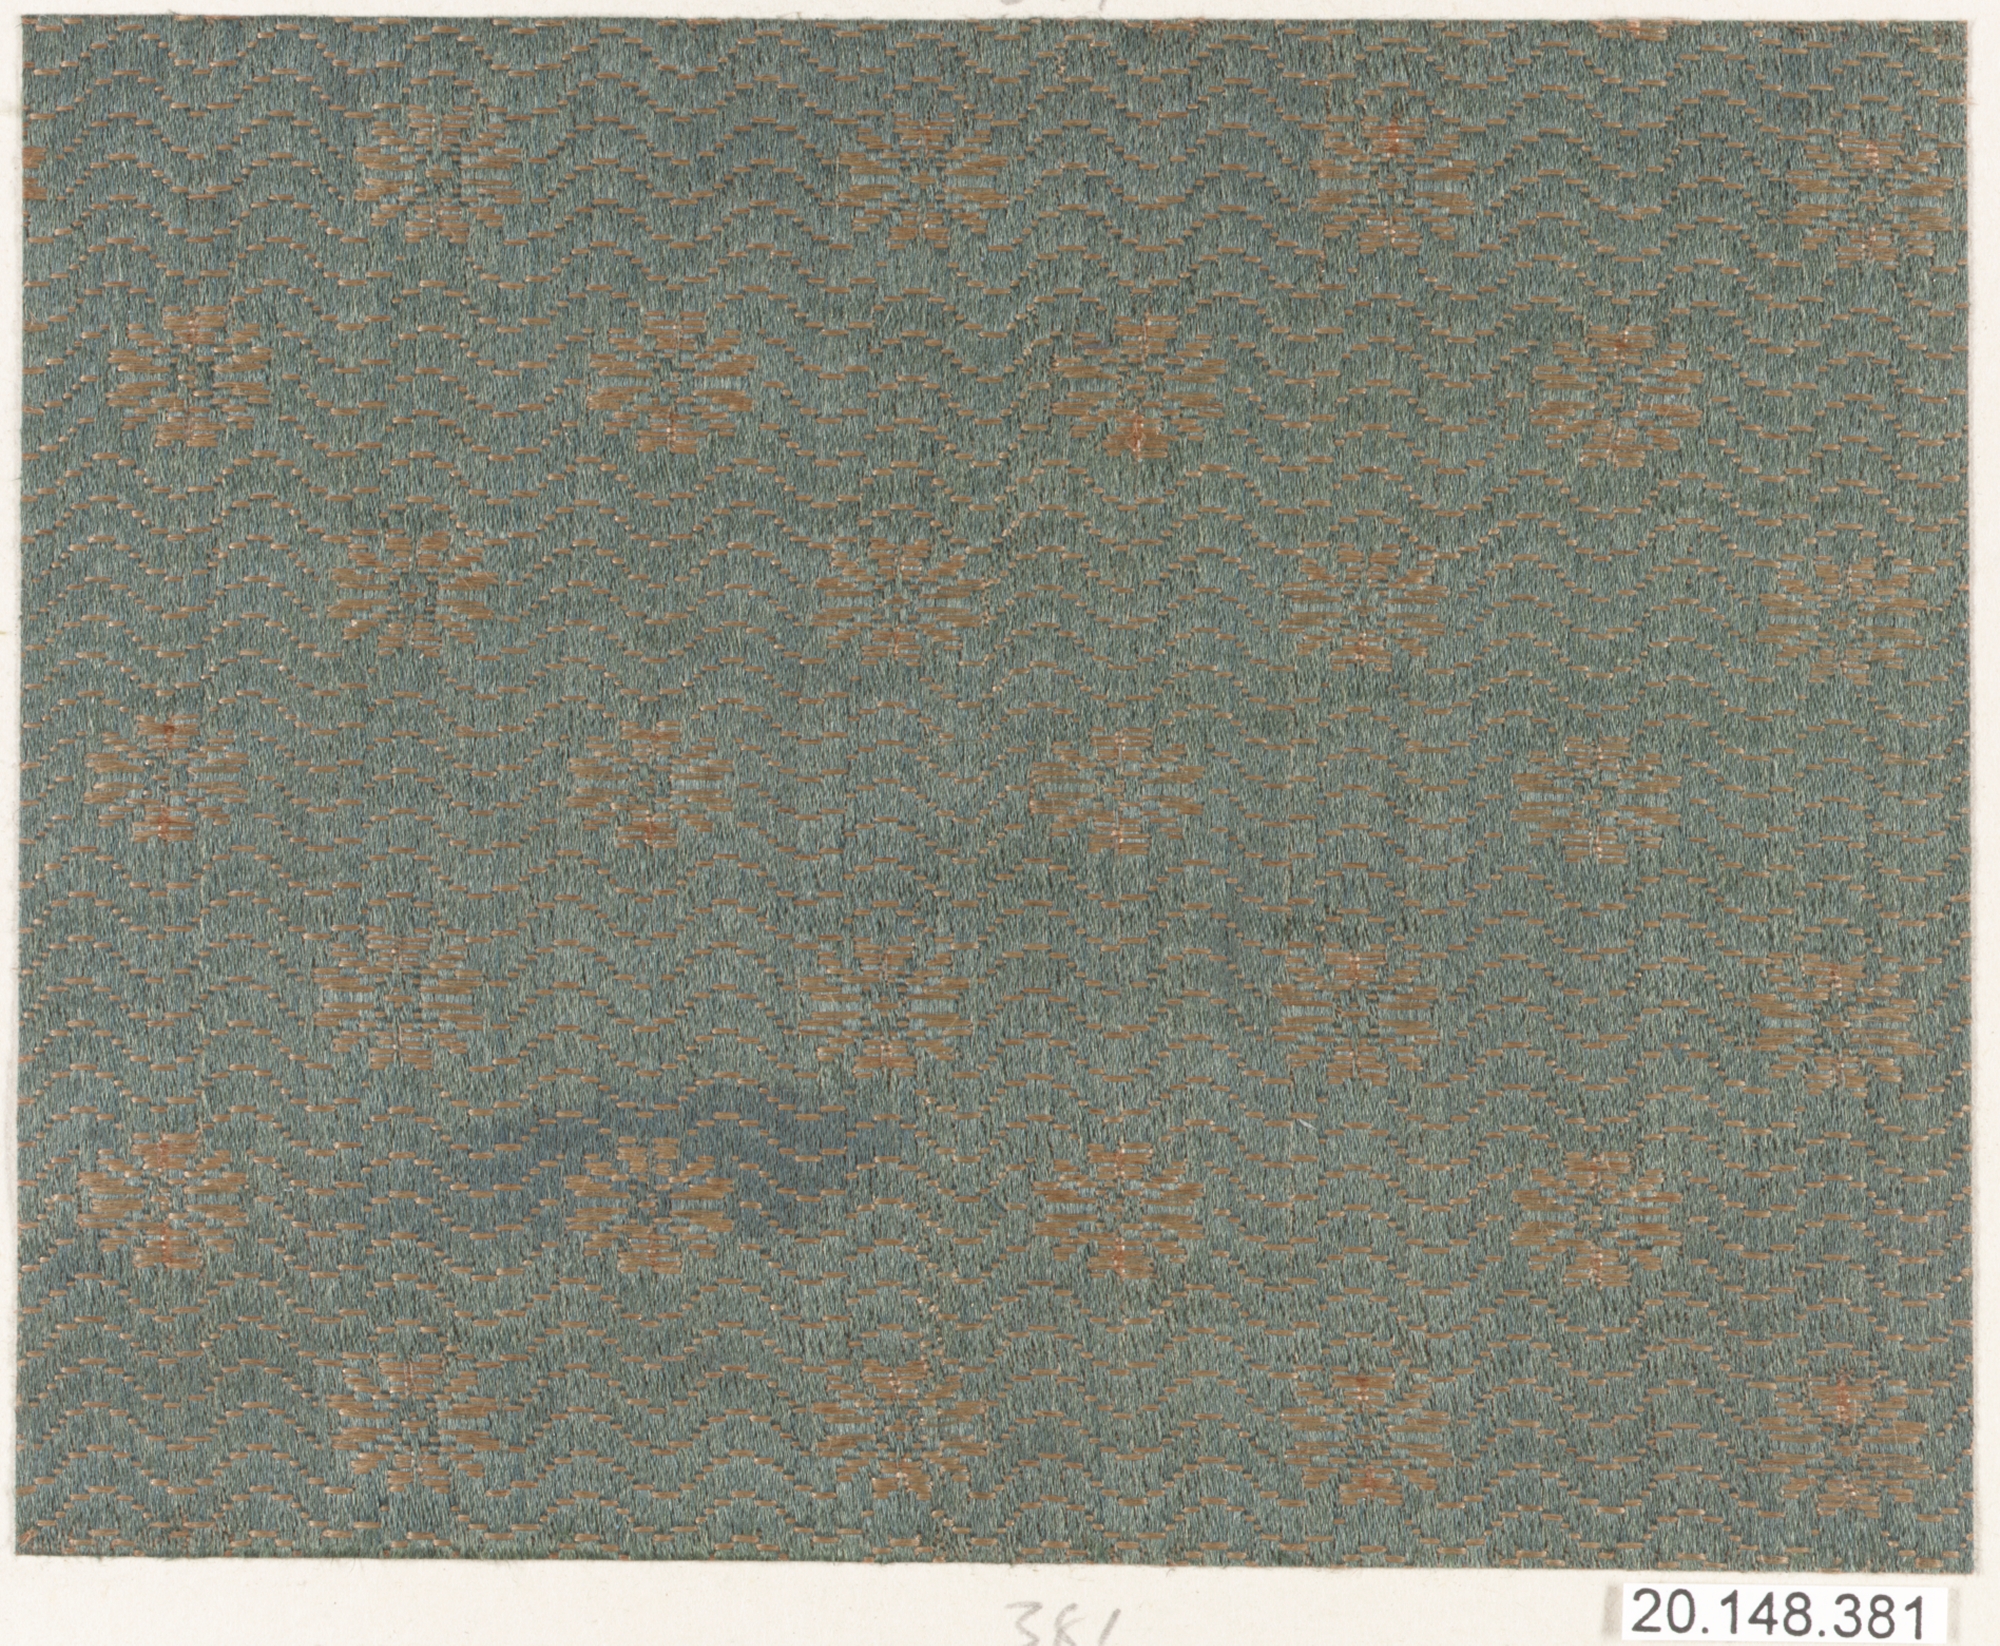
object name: piece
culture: japanese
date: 1701-1800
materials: silk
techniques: compound weave